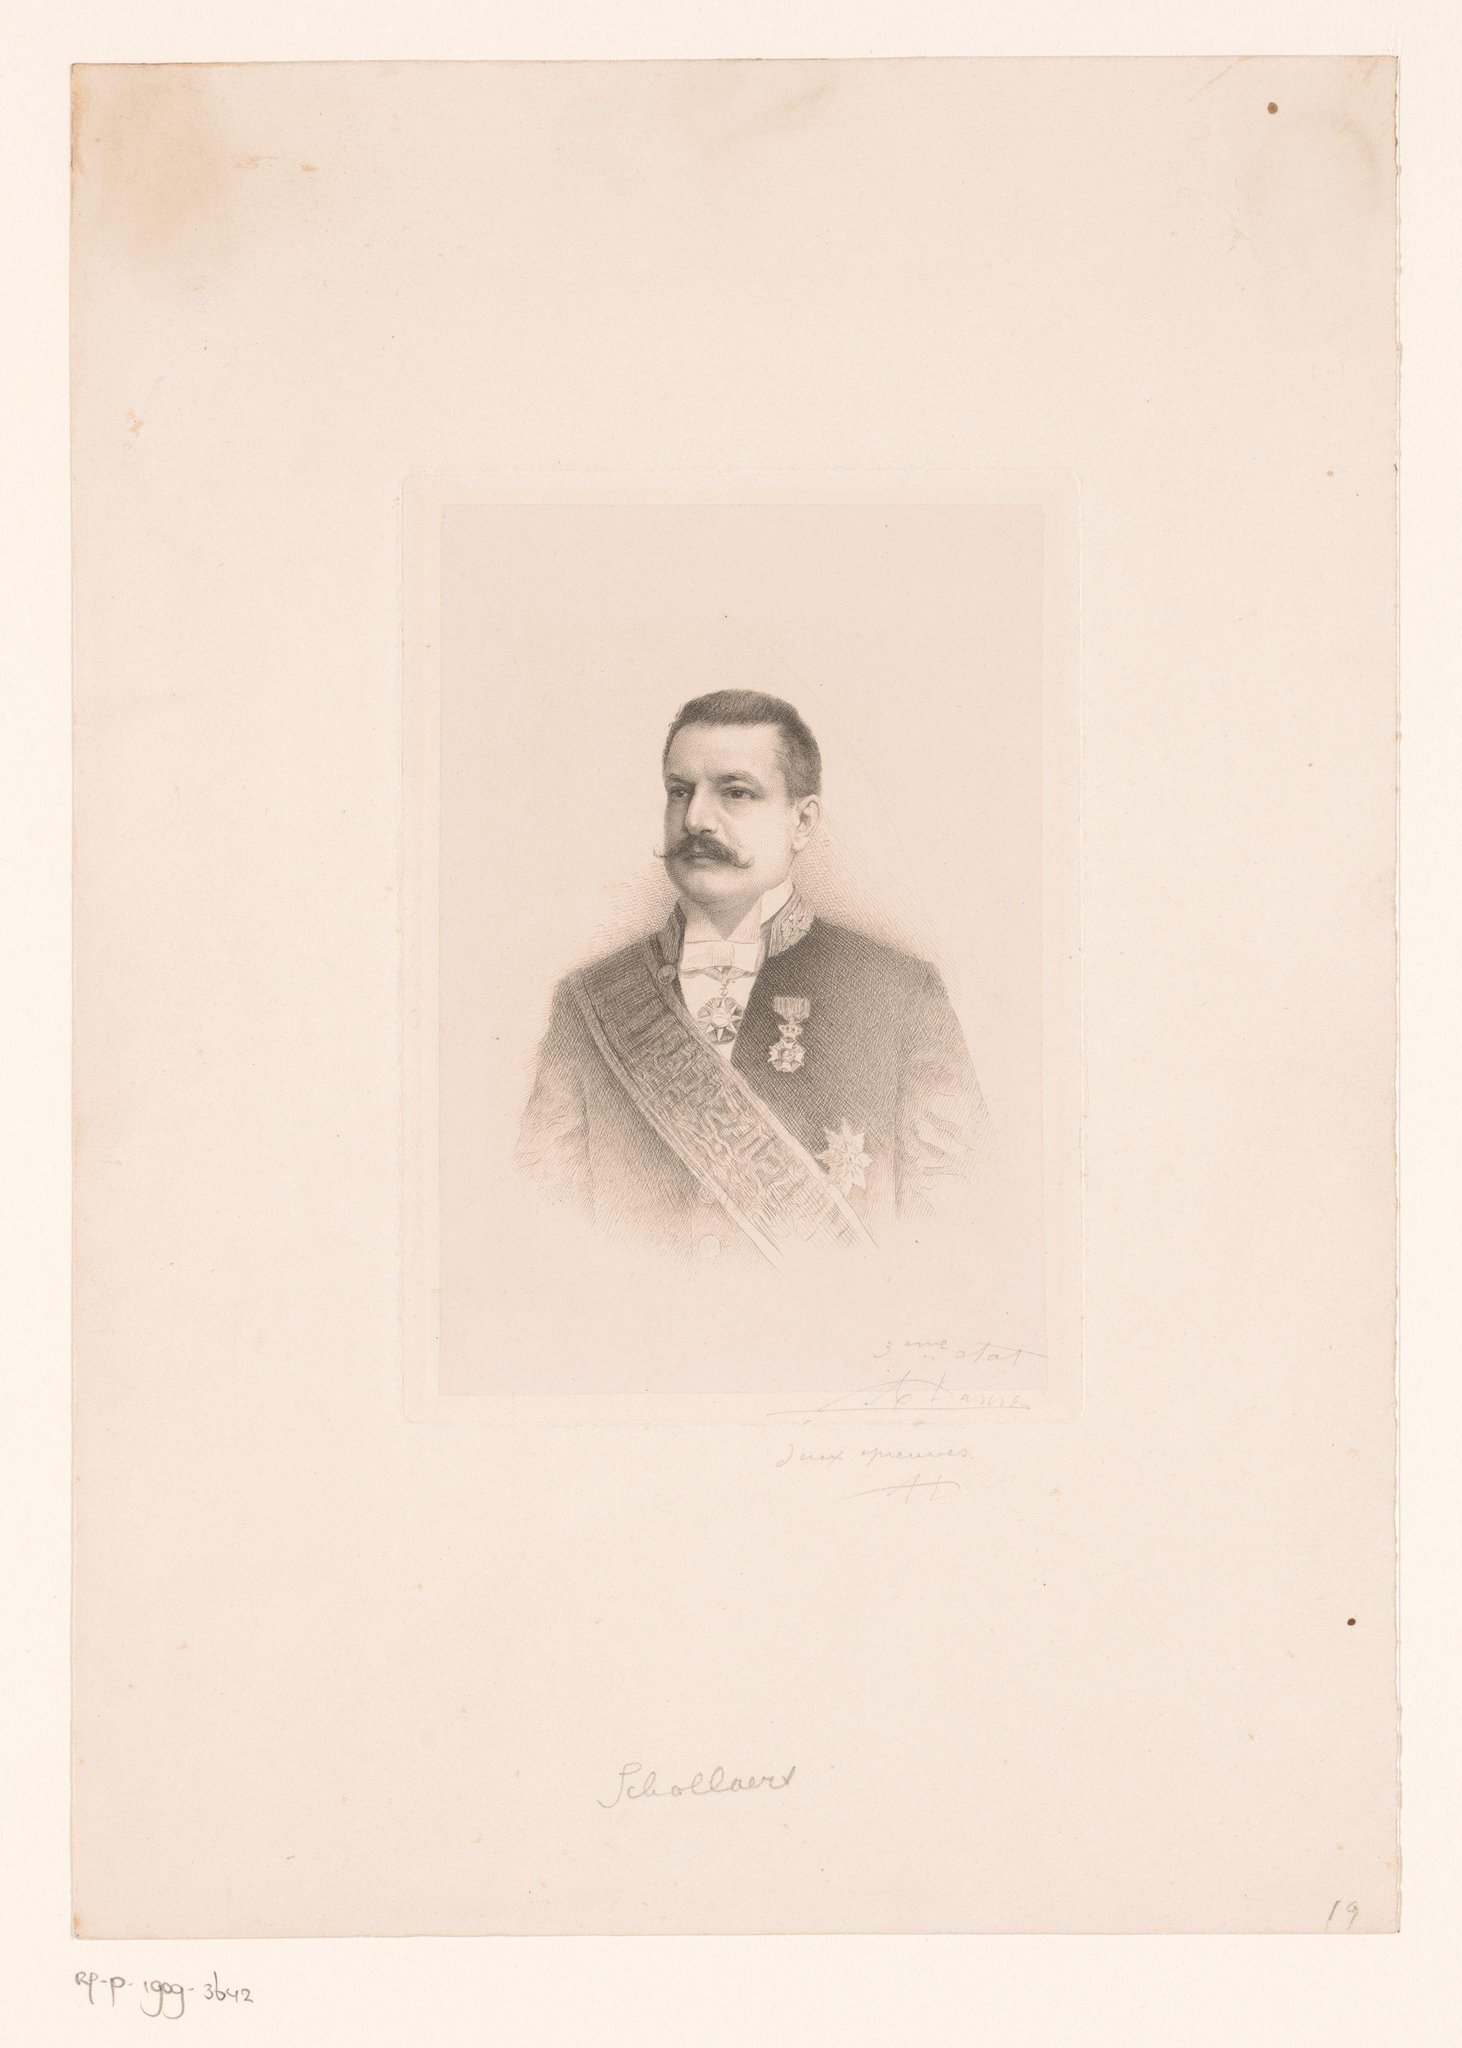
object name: print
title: Portret van Frans Schollaert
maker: auguste danse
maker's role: print maker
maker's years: 1829-1929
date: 1888-1909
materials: paper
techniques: etching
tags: politician, historical person (...) - historical person (...) portrayed alone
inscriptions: collector's mark: Lugt 2228, annotation: ‘3eme etat; deux epreuves’